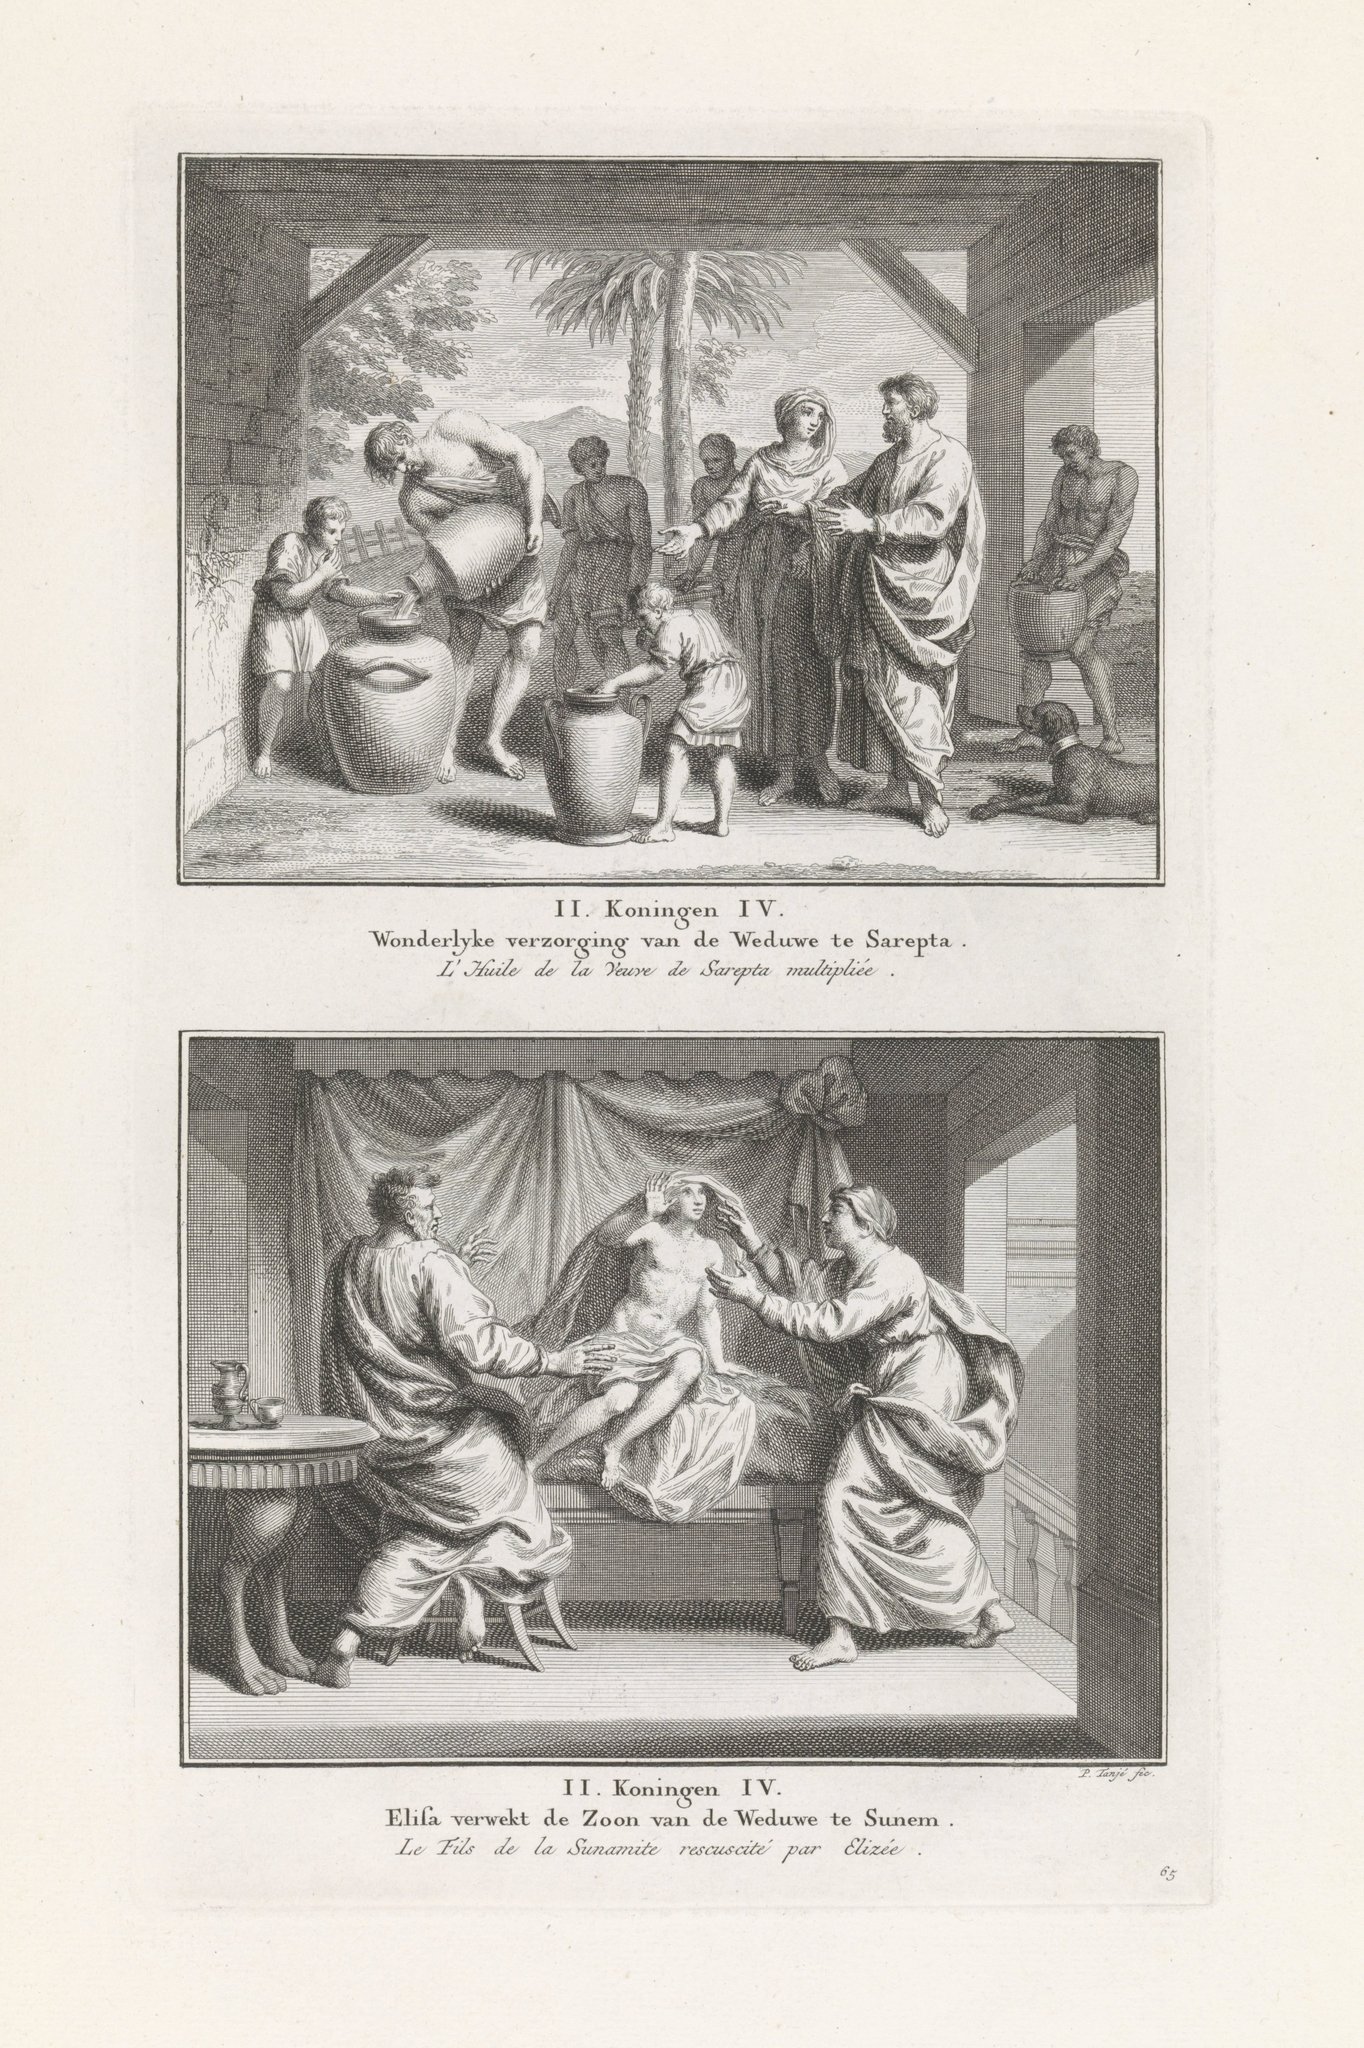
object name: print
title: Wonderlyke verzorging van de Weduwe te Sarepta (...) / Elisa verwekt de Zoon van de Weduwe te Sunem (...)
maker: pieter tanjé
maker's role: draughtsman, print maker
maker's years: 1706-1761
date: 1716-1761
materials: paper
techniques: engraving, etching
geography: amsterdam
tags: the widow's oil: the little oil a woman has in store increases so that she and her son are able to fill many borrowed jars with it (2 kings 4:1-7), elisha finds the son of the shunammite woman lying on his bed and prays to god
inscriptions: collector's mark: Lugt 2233, collector's mark: Lugt 3937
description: Prent mogelijk gebruikt in: Hamelsveld, Ysbrand van. De gewigtigste geschiedenissen des Bybels, afgebeeld in twee honderd twee en vĳftig printverbeeldingen (...) met eene zaaklĳke uitbreiding opgehelderd. Amsterdam: Jan de Groot, Gerrit Warnars, Petrus van Hengst, Dordrecht: Abraham Blussé, Pieter Blussé, Leiden: Samuel Luchtmans (III), Johannes Luchtmans, Harlingen: Volkert van der Plaats, 1791.